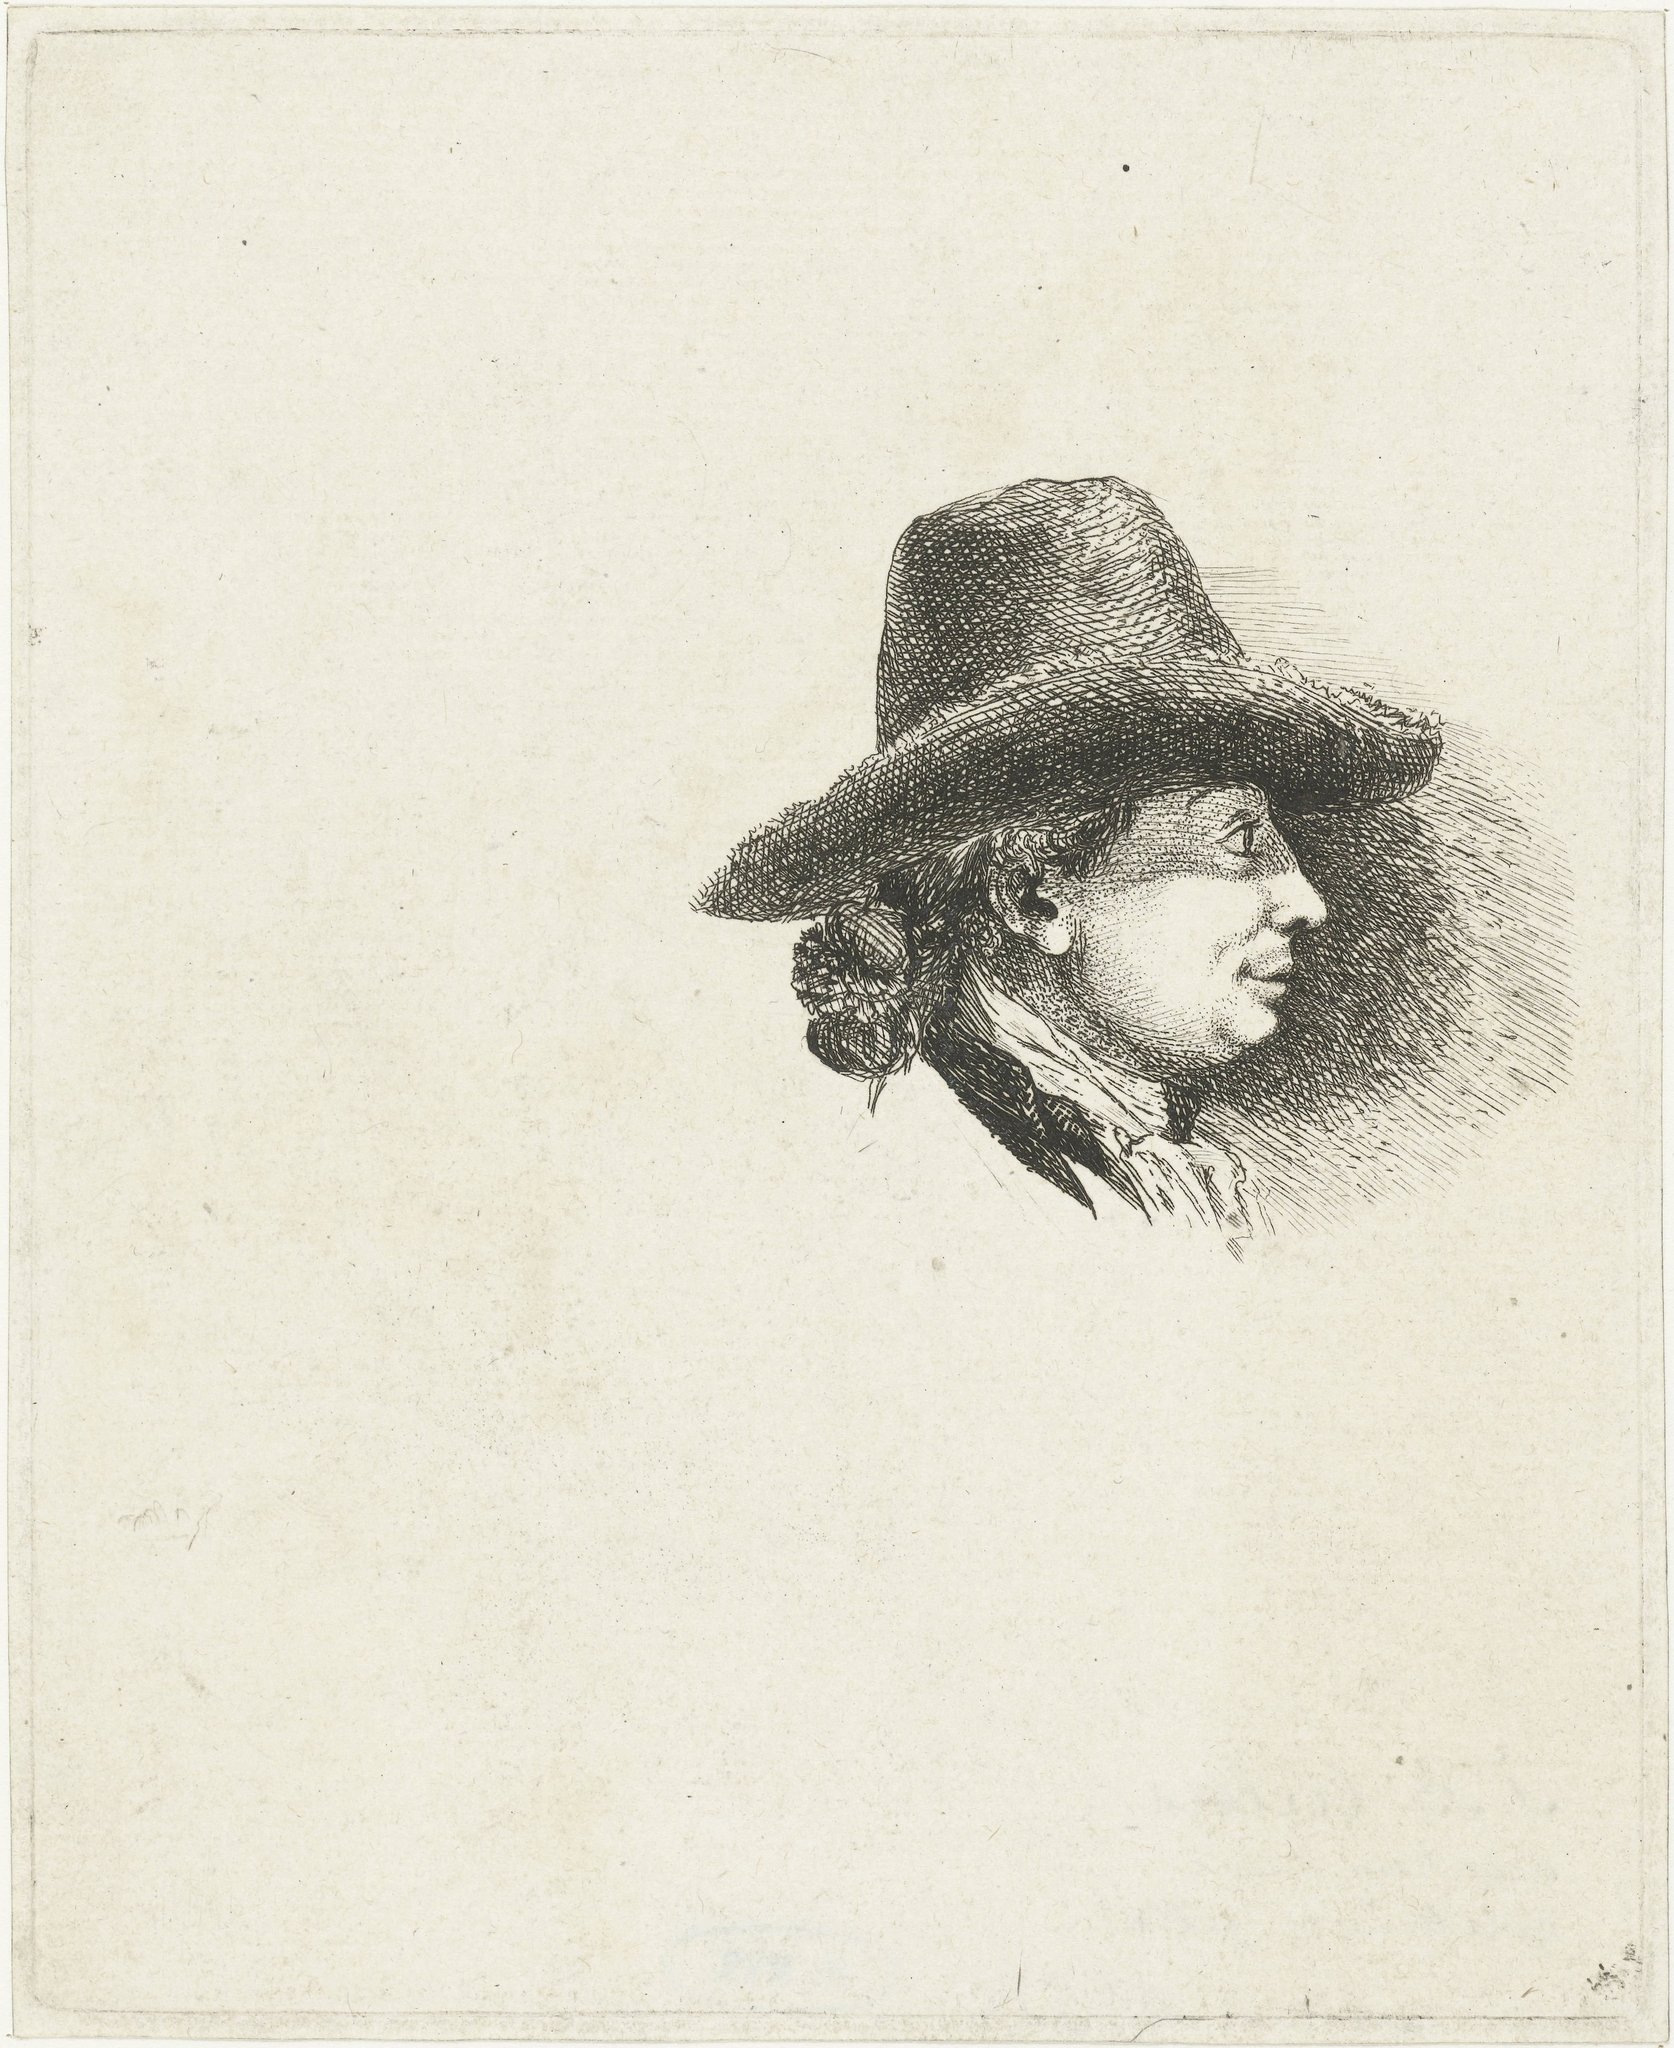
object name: print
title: Studieblad met portretten van Louis Bernard Coclers en zijn familie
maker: louis bernard coclers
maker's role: draughtsman, print maker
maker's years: 1741-1817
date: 1780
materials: paper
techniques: etching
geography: leiden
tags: liège, print maker, draughtsman, louis bernard coclers, the artist and his family, relatives, etc. (+ portrait, self-portrait of artist)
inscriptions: collector's mark: Lugt 2228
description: Portretbuste van Louis Bernard Coclers met zwarte hoed, naar rechts.